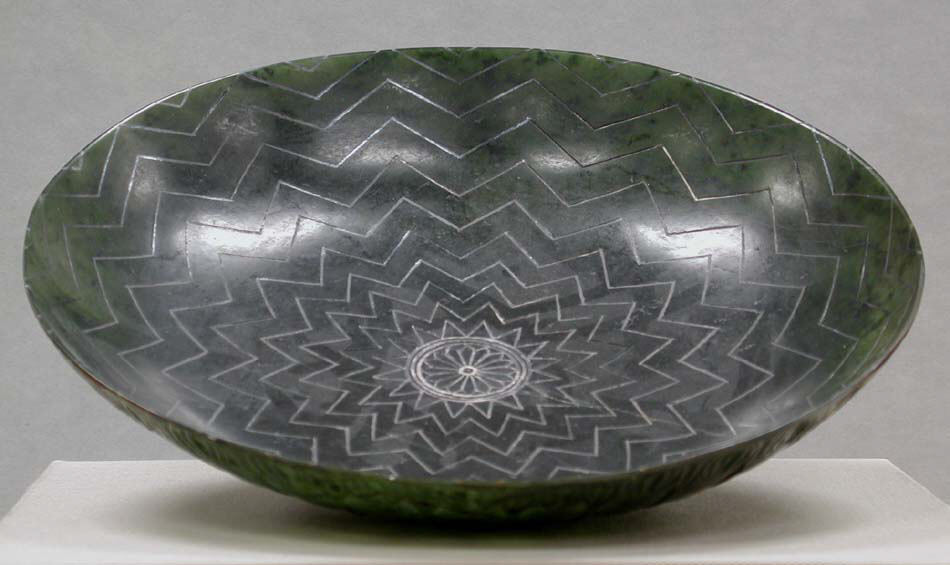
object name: dish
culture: indian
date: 1701-1800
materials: jade, silver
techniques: inlay